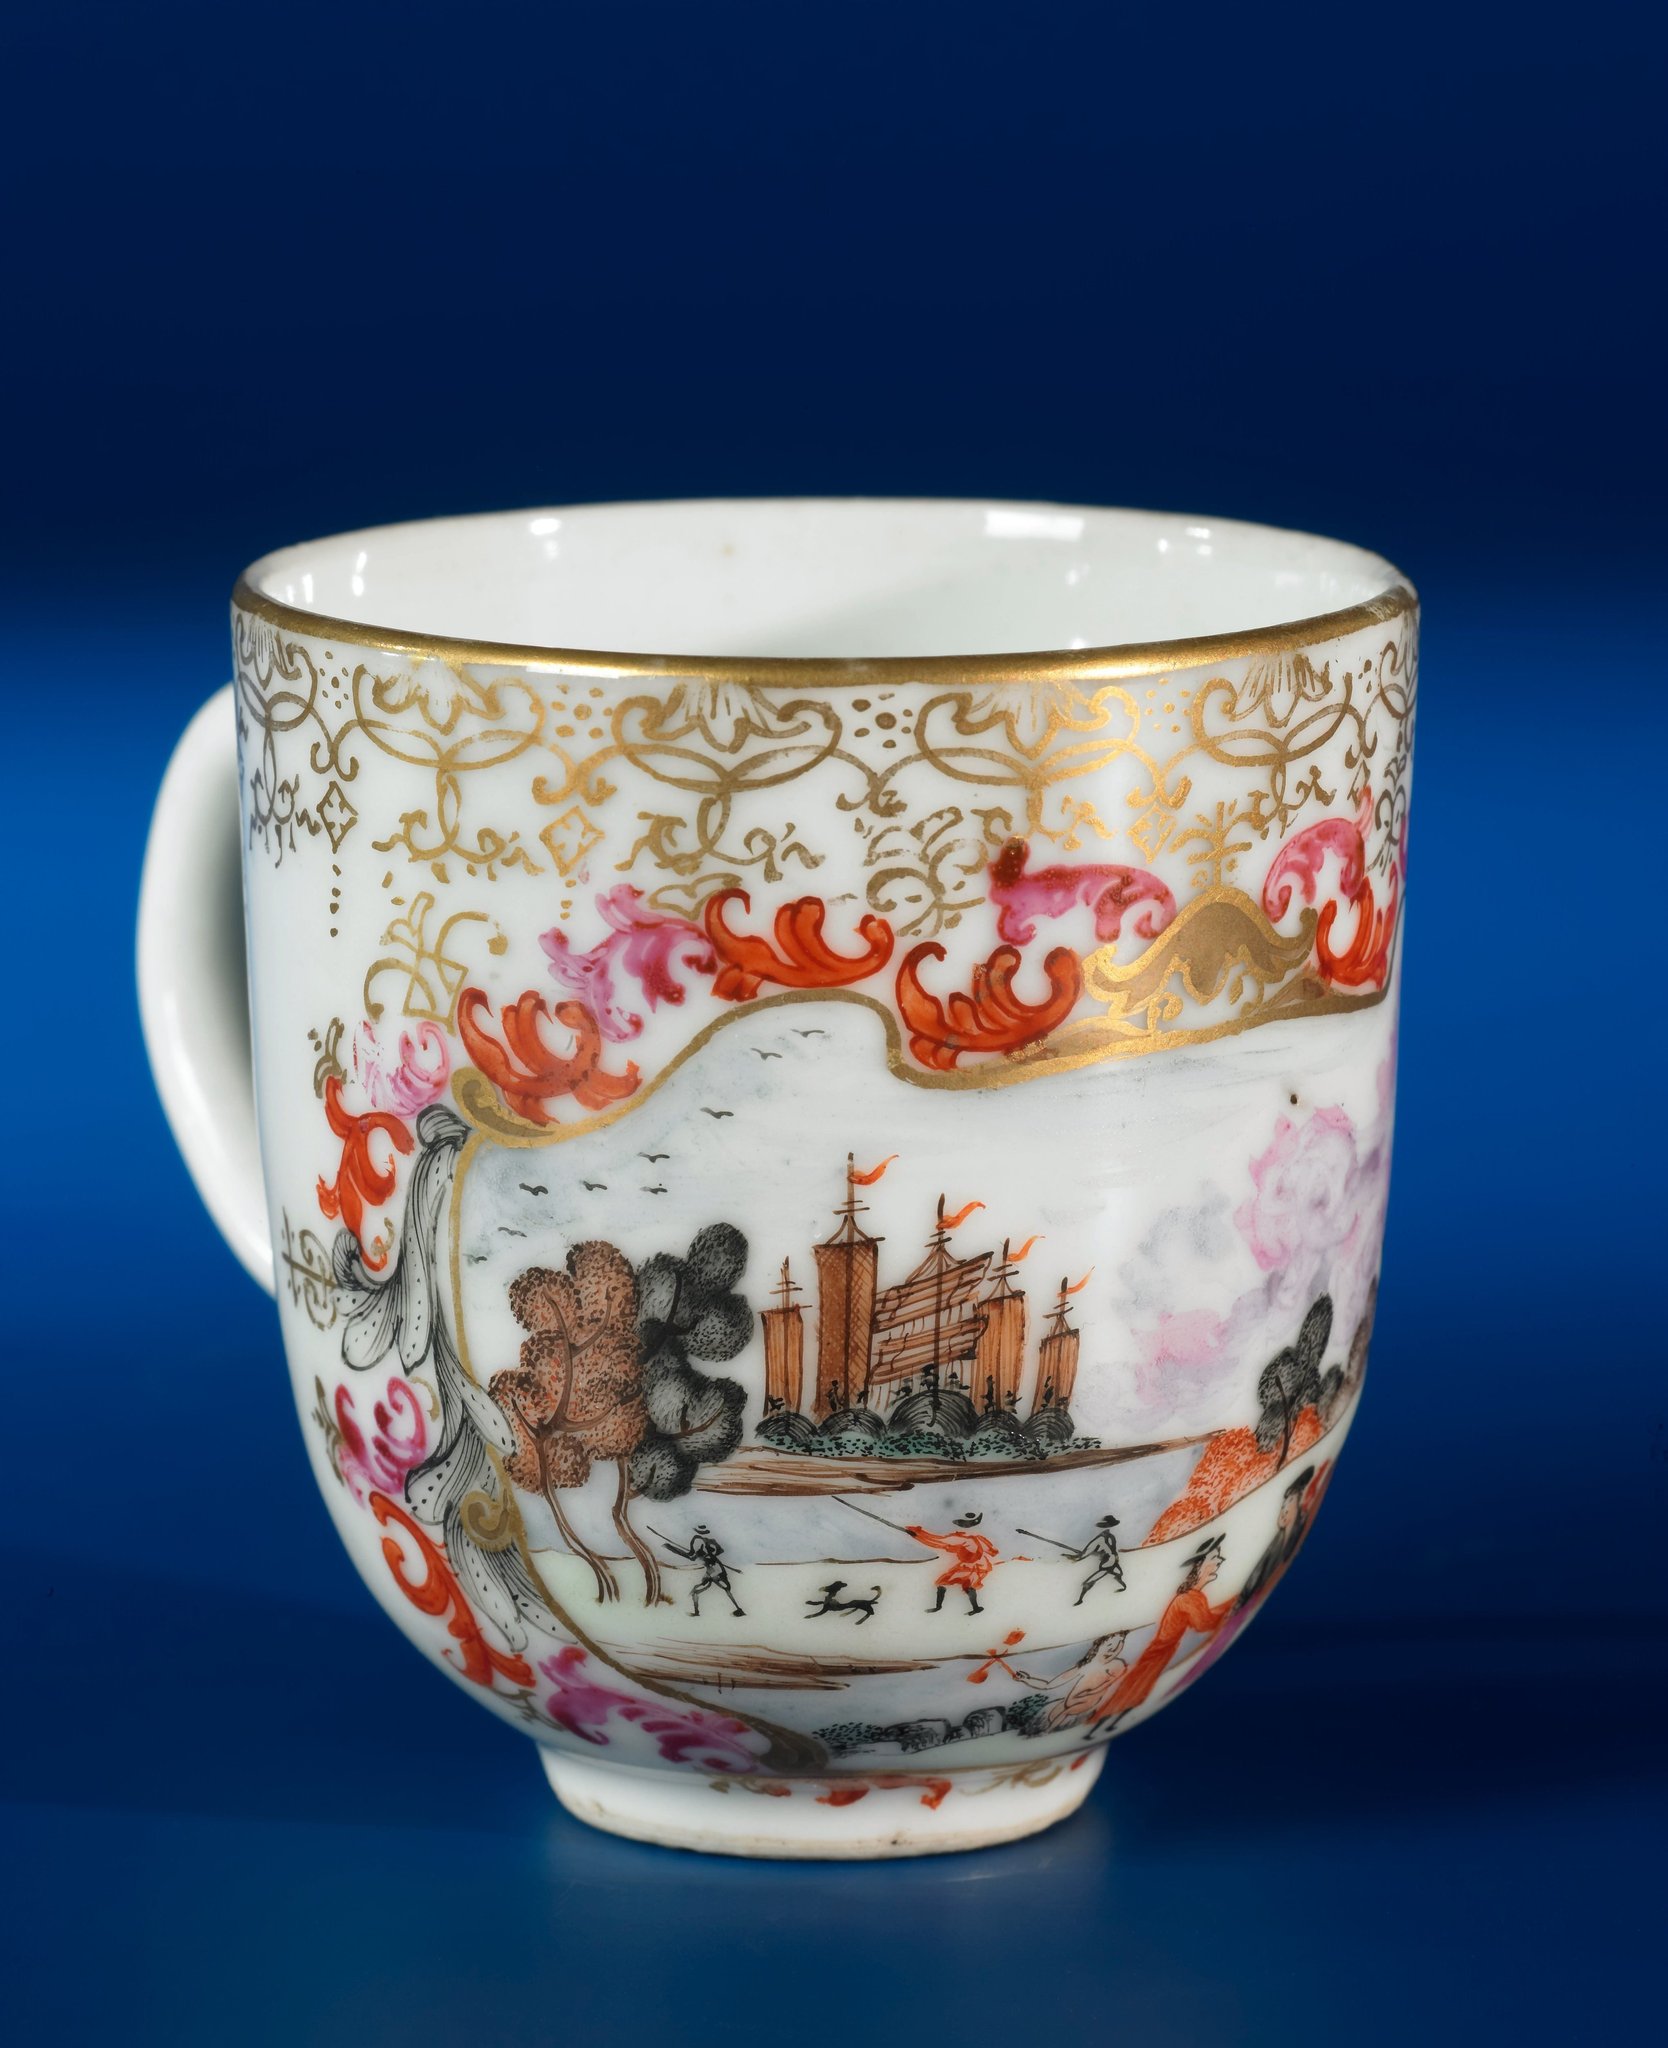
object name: cup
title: Cup with handle with a European waterlandscape in a panel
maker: Anonymous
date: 1740-1760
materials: glaze, gold, paint, porcelain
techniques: firing, gilding, turning, vitrification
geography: china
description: Hoge kop op een voetring, met oor. Gedecoreerd in emailkleuren, met een waterlandschap. Binnen een cartouche zijn verschillende Europese figuurtjes, een kerkje en een hondje afgebeeld, op de achtergrond een groot zeilschip. Rondom een decoratief ornament. De decoratie is ontleend aan Meissen porselein. Dit porselein werd vaak met havengezichten gedecoreerd. In China werd dit (duurdere) Meissen porselein gekopieerd. Het decoratieve patroon dat men vaak aantreft op Meissen porselein is een zich herhalend patroon van krullen en lijnen die door elkaar lopen, meestal in goud geschilderd.